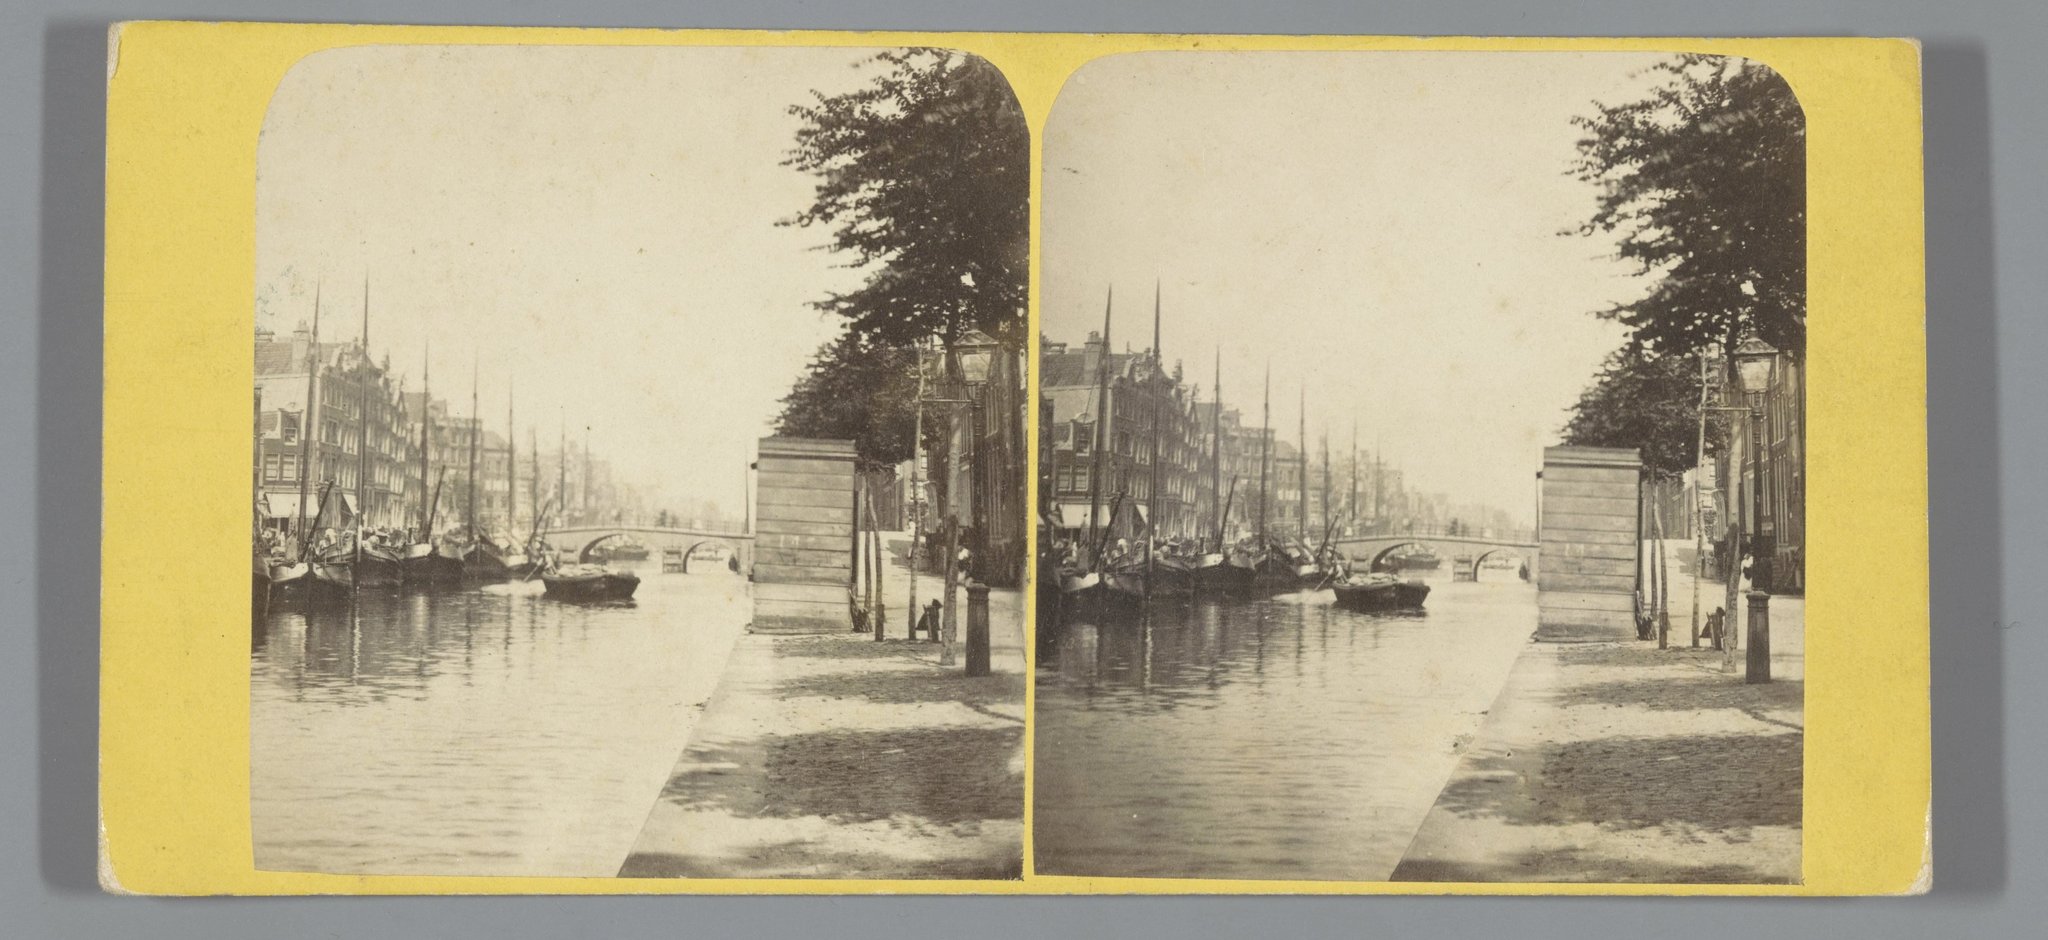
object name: stereograph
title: Gezicht op de Prinsengracht bij de Leliegracht in Amsterdam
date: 1860-1885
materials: cardboard, photographic support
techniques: albumen print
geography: amsterdam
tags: canals, waters (in city)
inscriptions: inscription: ‘No. 211./ DE PRINSENGRACHT/ BIJ DE/ Leliegracht te Amsterdam./ A. JAGER, WATER 110, TE AMSTERDAM.’, annotation: ‘[...]/ Nr 64’